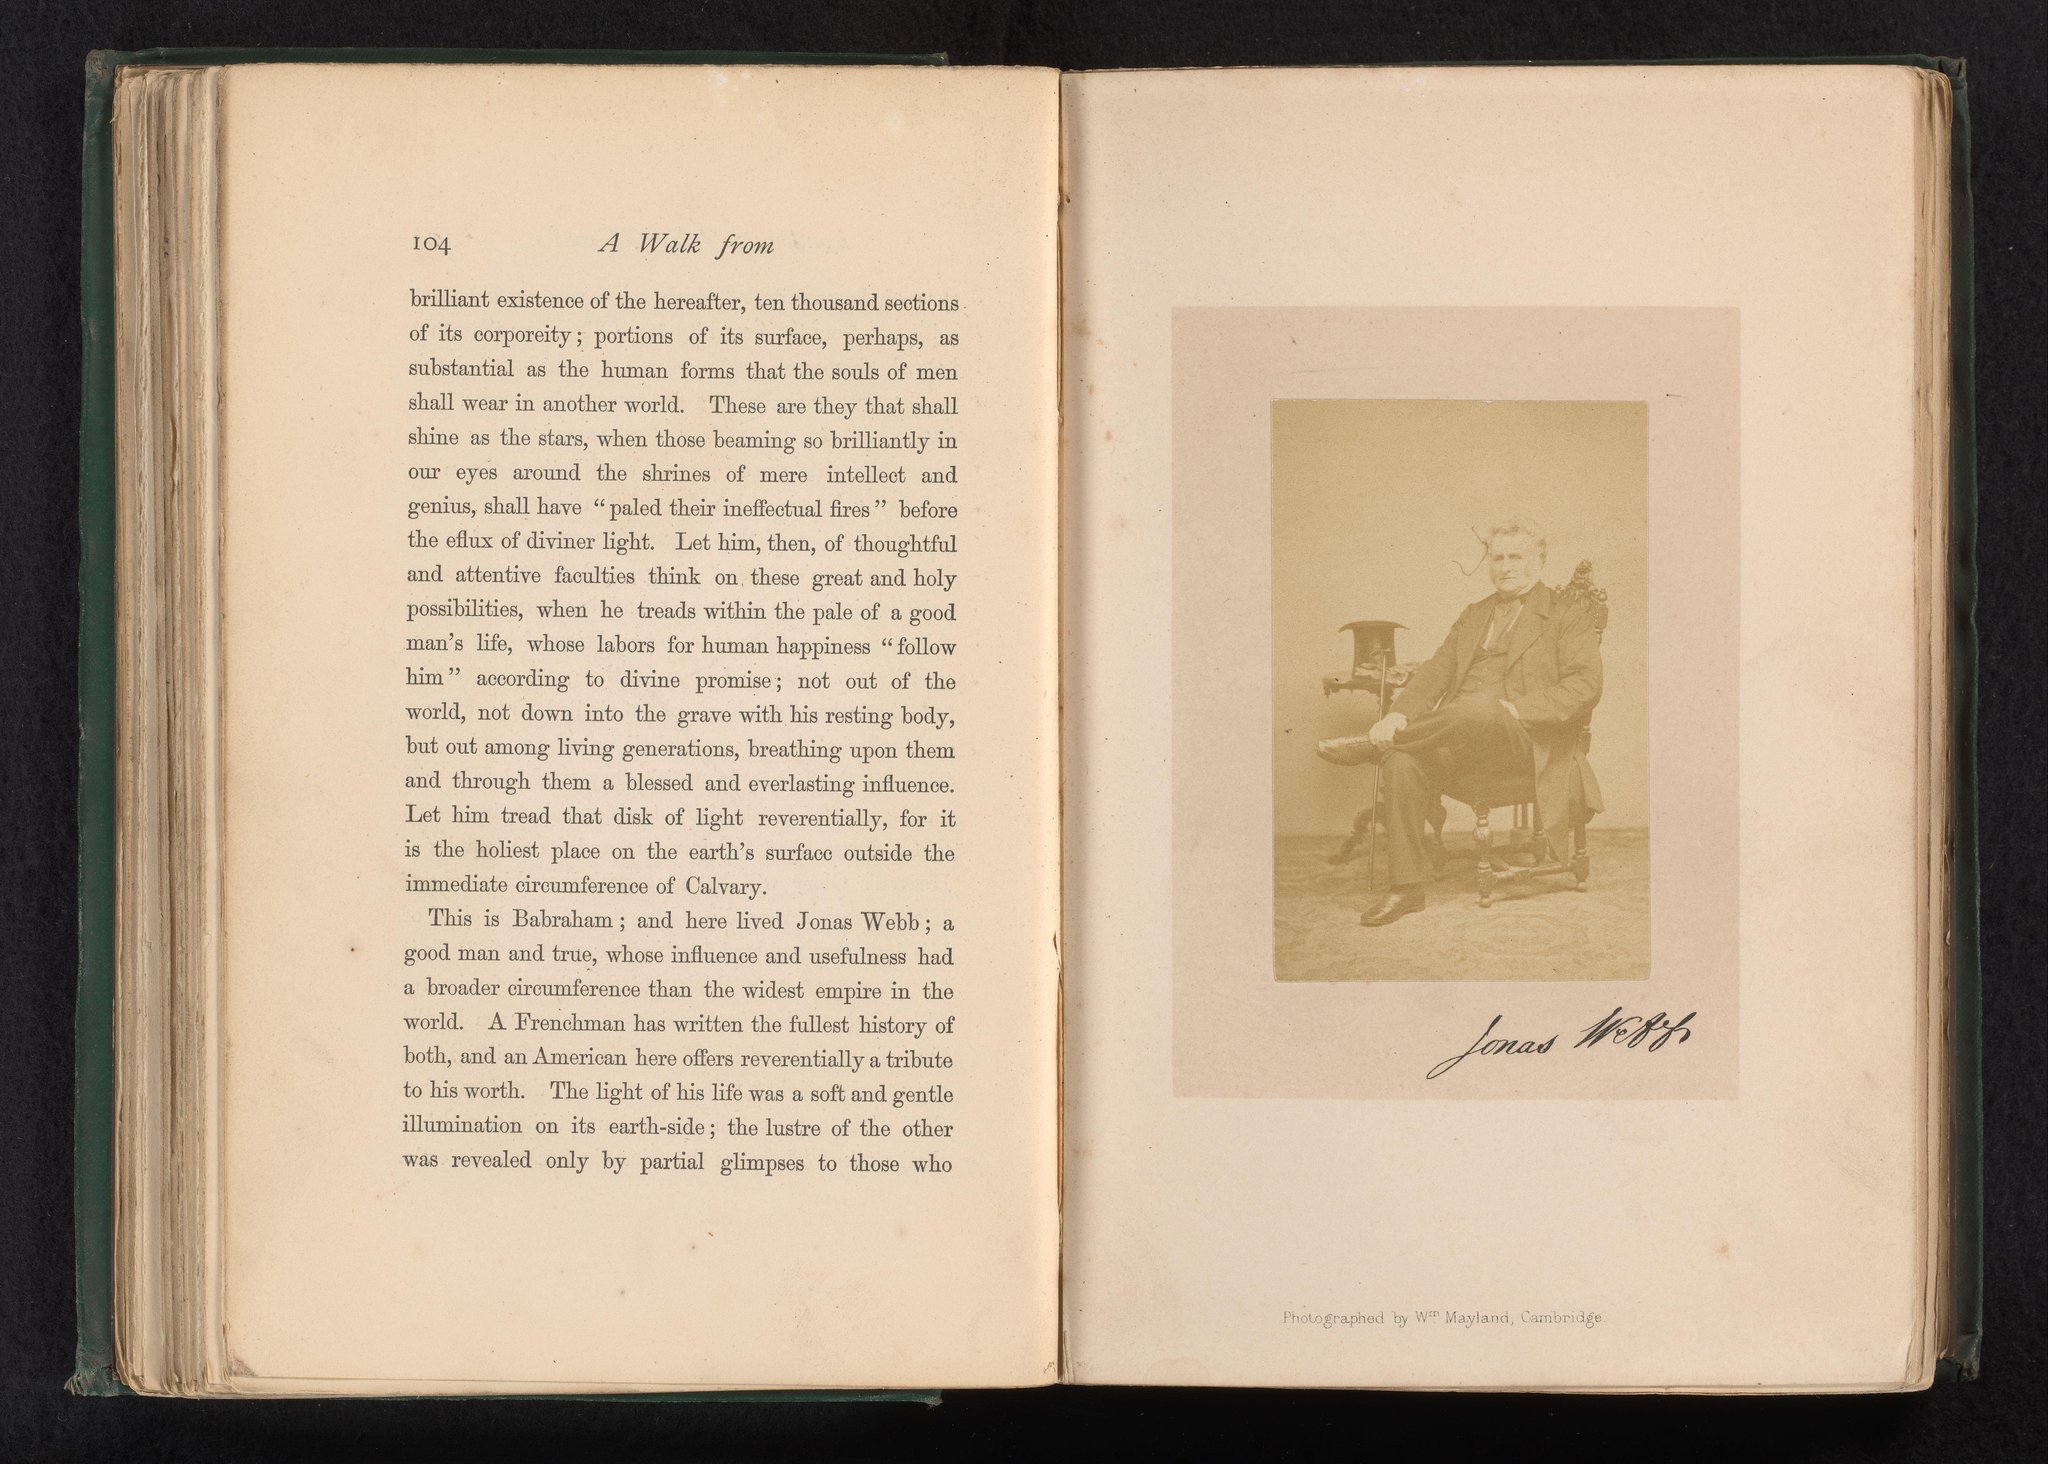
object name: page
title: Portret van Jonas Webb met wandelstok en hoed naast zich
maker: william mayland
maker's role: fotograaf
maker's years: 1821-1907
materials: paper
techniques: albumen print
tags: historical persons, farmers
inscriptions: address: ‘Photographed by Wm Mayland, Cambridge’, inscription: ‘Jonas Webb’